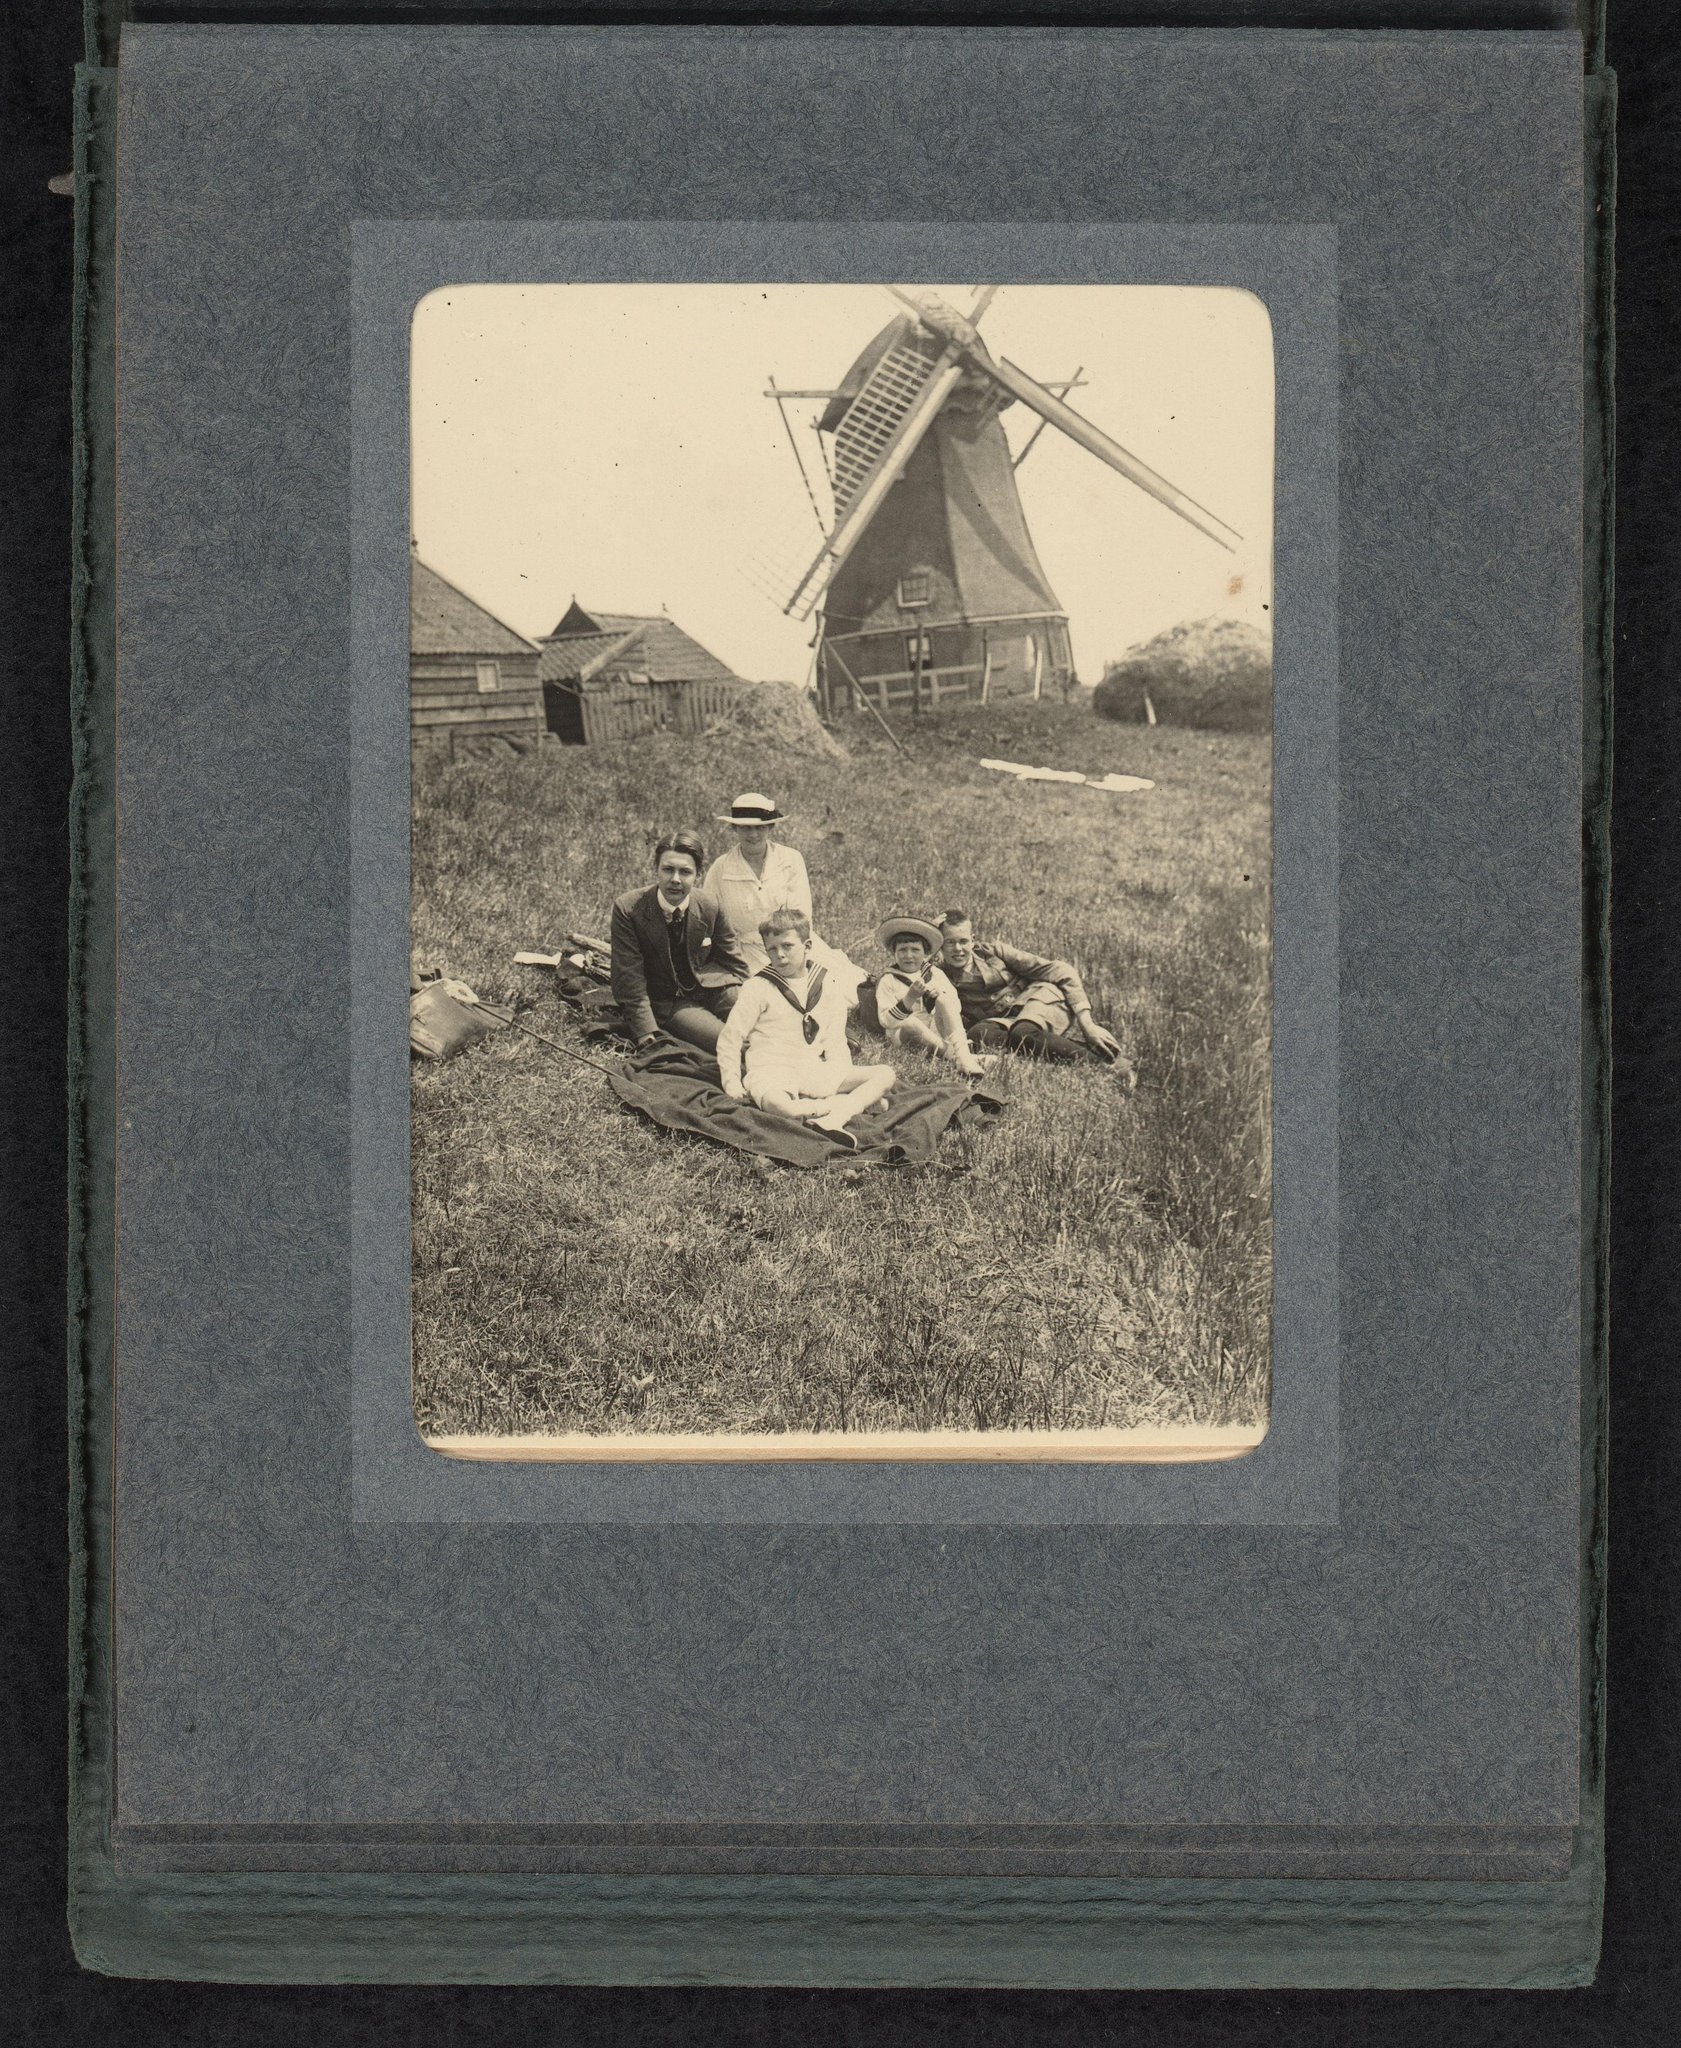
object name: album leaf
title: Caroline, Carel en Frank van den Berg met twee neven, vermoedelijk Norbert en Willem van den Berg, in een grasveld bij een windmolen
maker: hendrik herman van den berg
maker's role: amateurfotograaf, jurist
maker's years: 1875-1944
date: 1918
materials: paper, cardboard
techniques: gelatin silver print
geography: amsterdam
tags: norbert van den berg (1901-1972), the hague, caroline louise van den berg-van den berg, carel frederik van den berg (cay), frank willem van den berg (1912-1998), amsterdam, willem jacob van den berg, family life, windmill